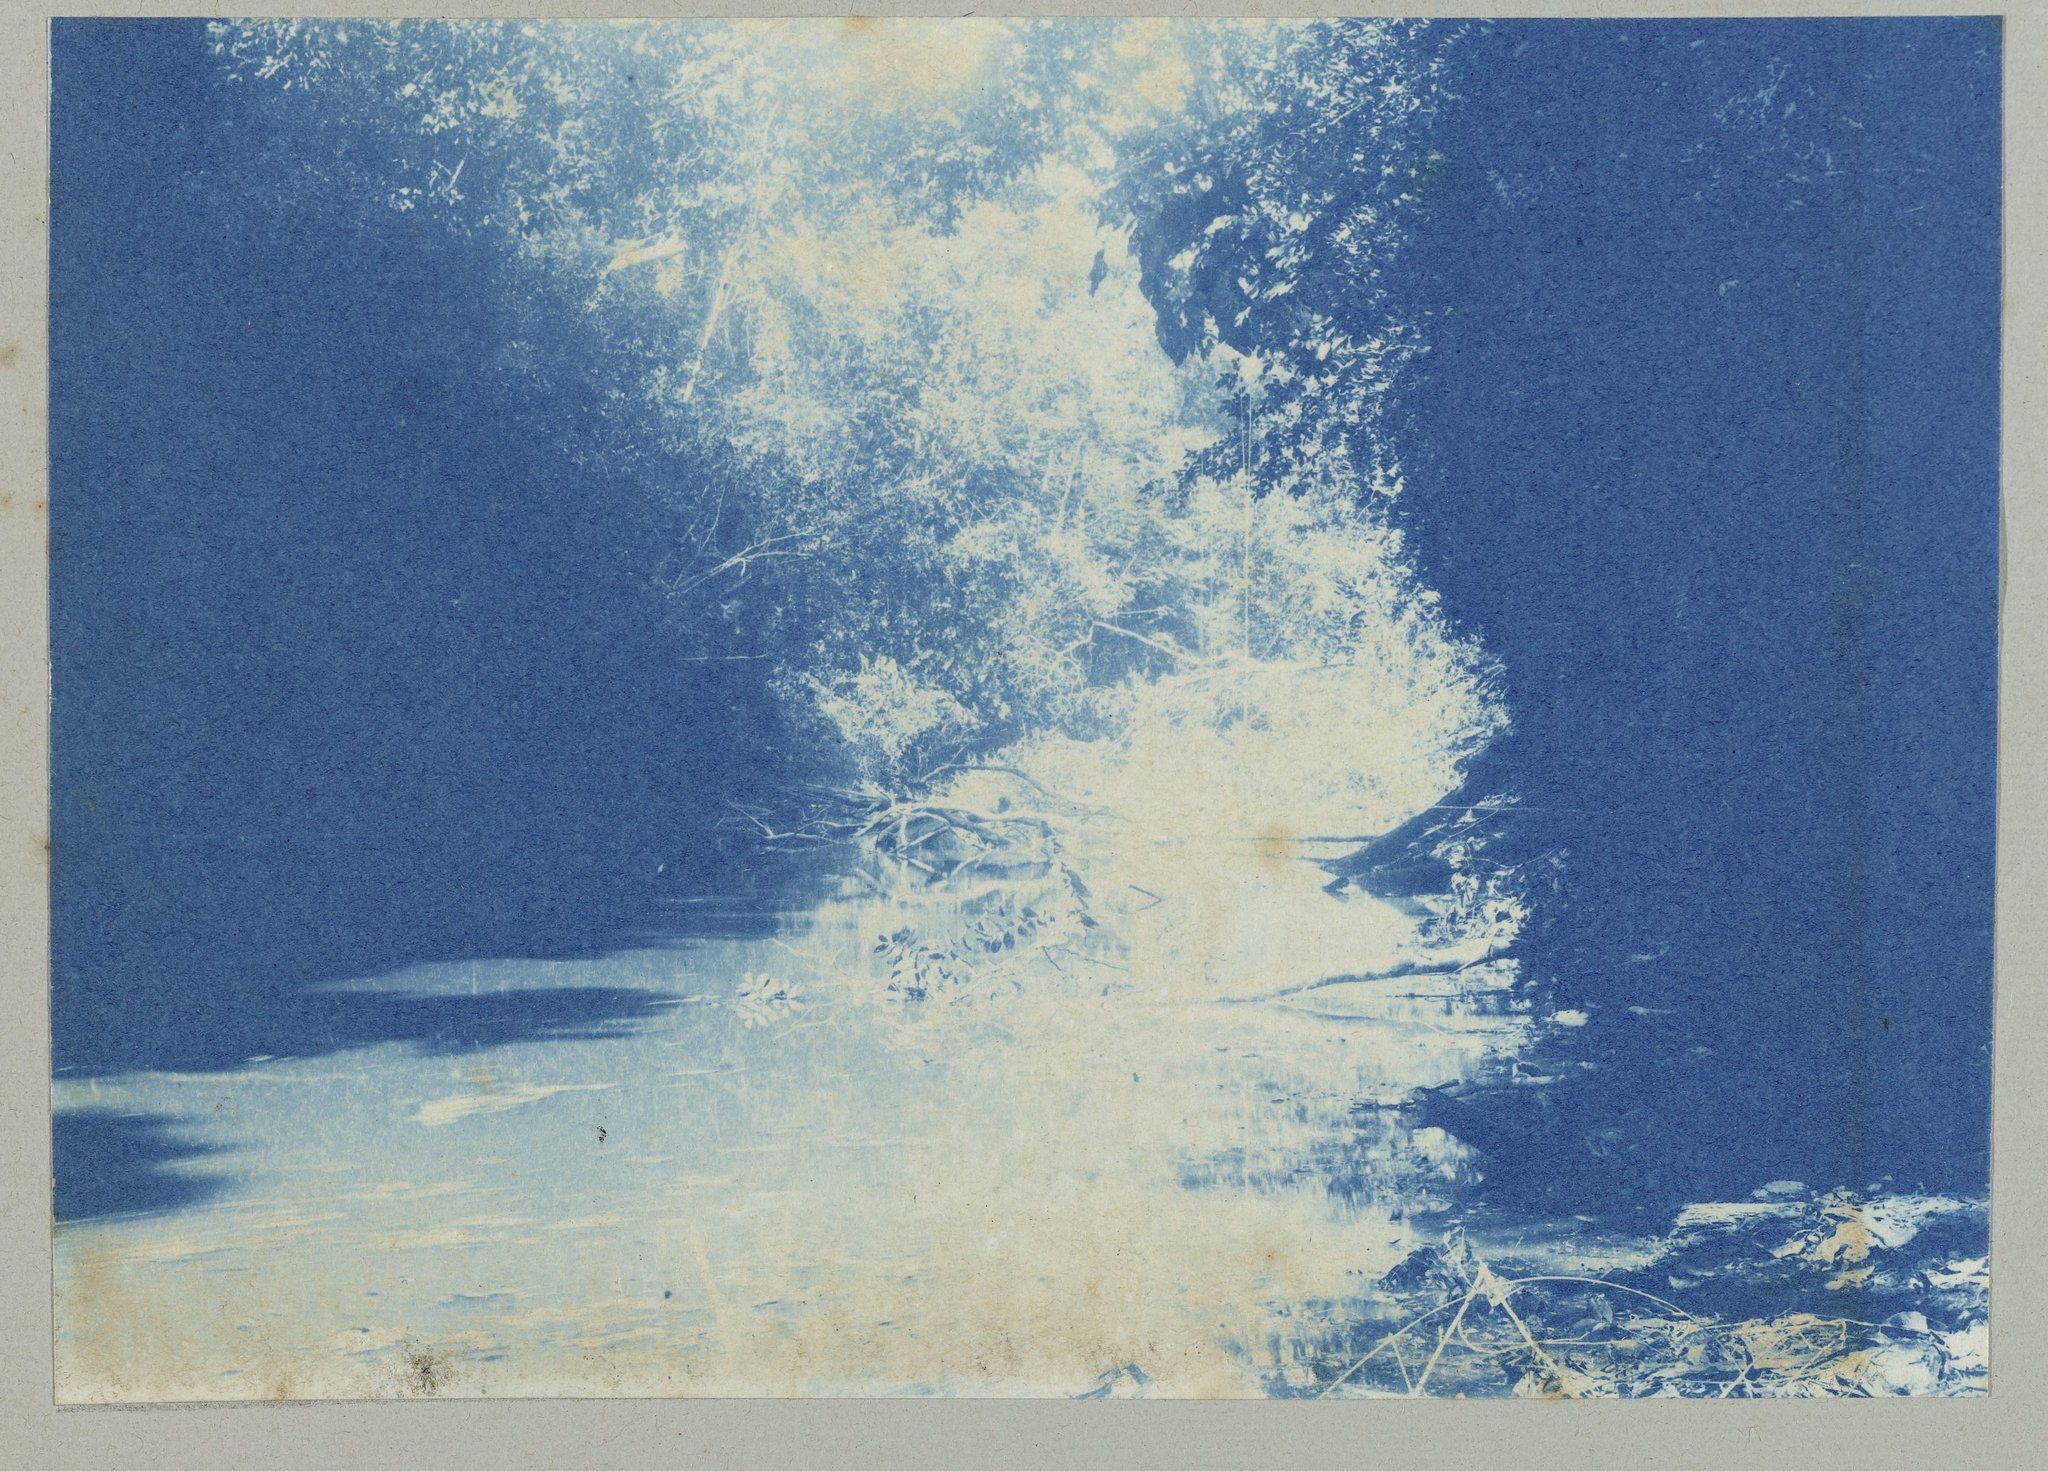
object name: photograph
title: Stroomversnelling in de Mindrineti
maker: hendrik doijer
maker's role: engineer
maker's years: 1863-1925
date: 1903-1910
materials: photographic support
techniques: cyanotype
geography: suriname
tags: suriname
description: Stroomversnelling in de Miendrieneti Kreek. Onderdeel van het fotoalbum Souvenir de Voyage (deel 1), over het leven van de familie Doijer in en rond de plantage Ma Retraite in Suriname in de jaren 1903-1910.